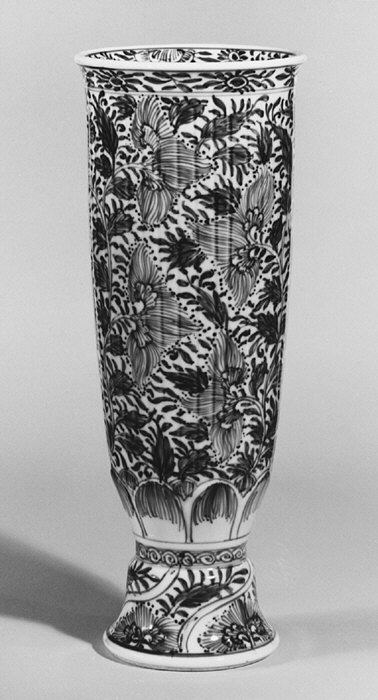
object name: beaker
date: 1700-1720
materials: hard paste porcelain